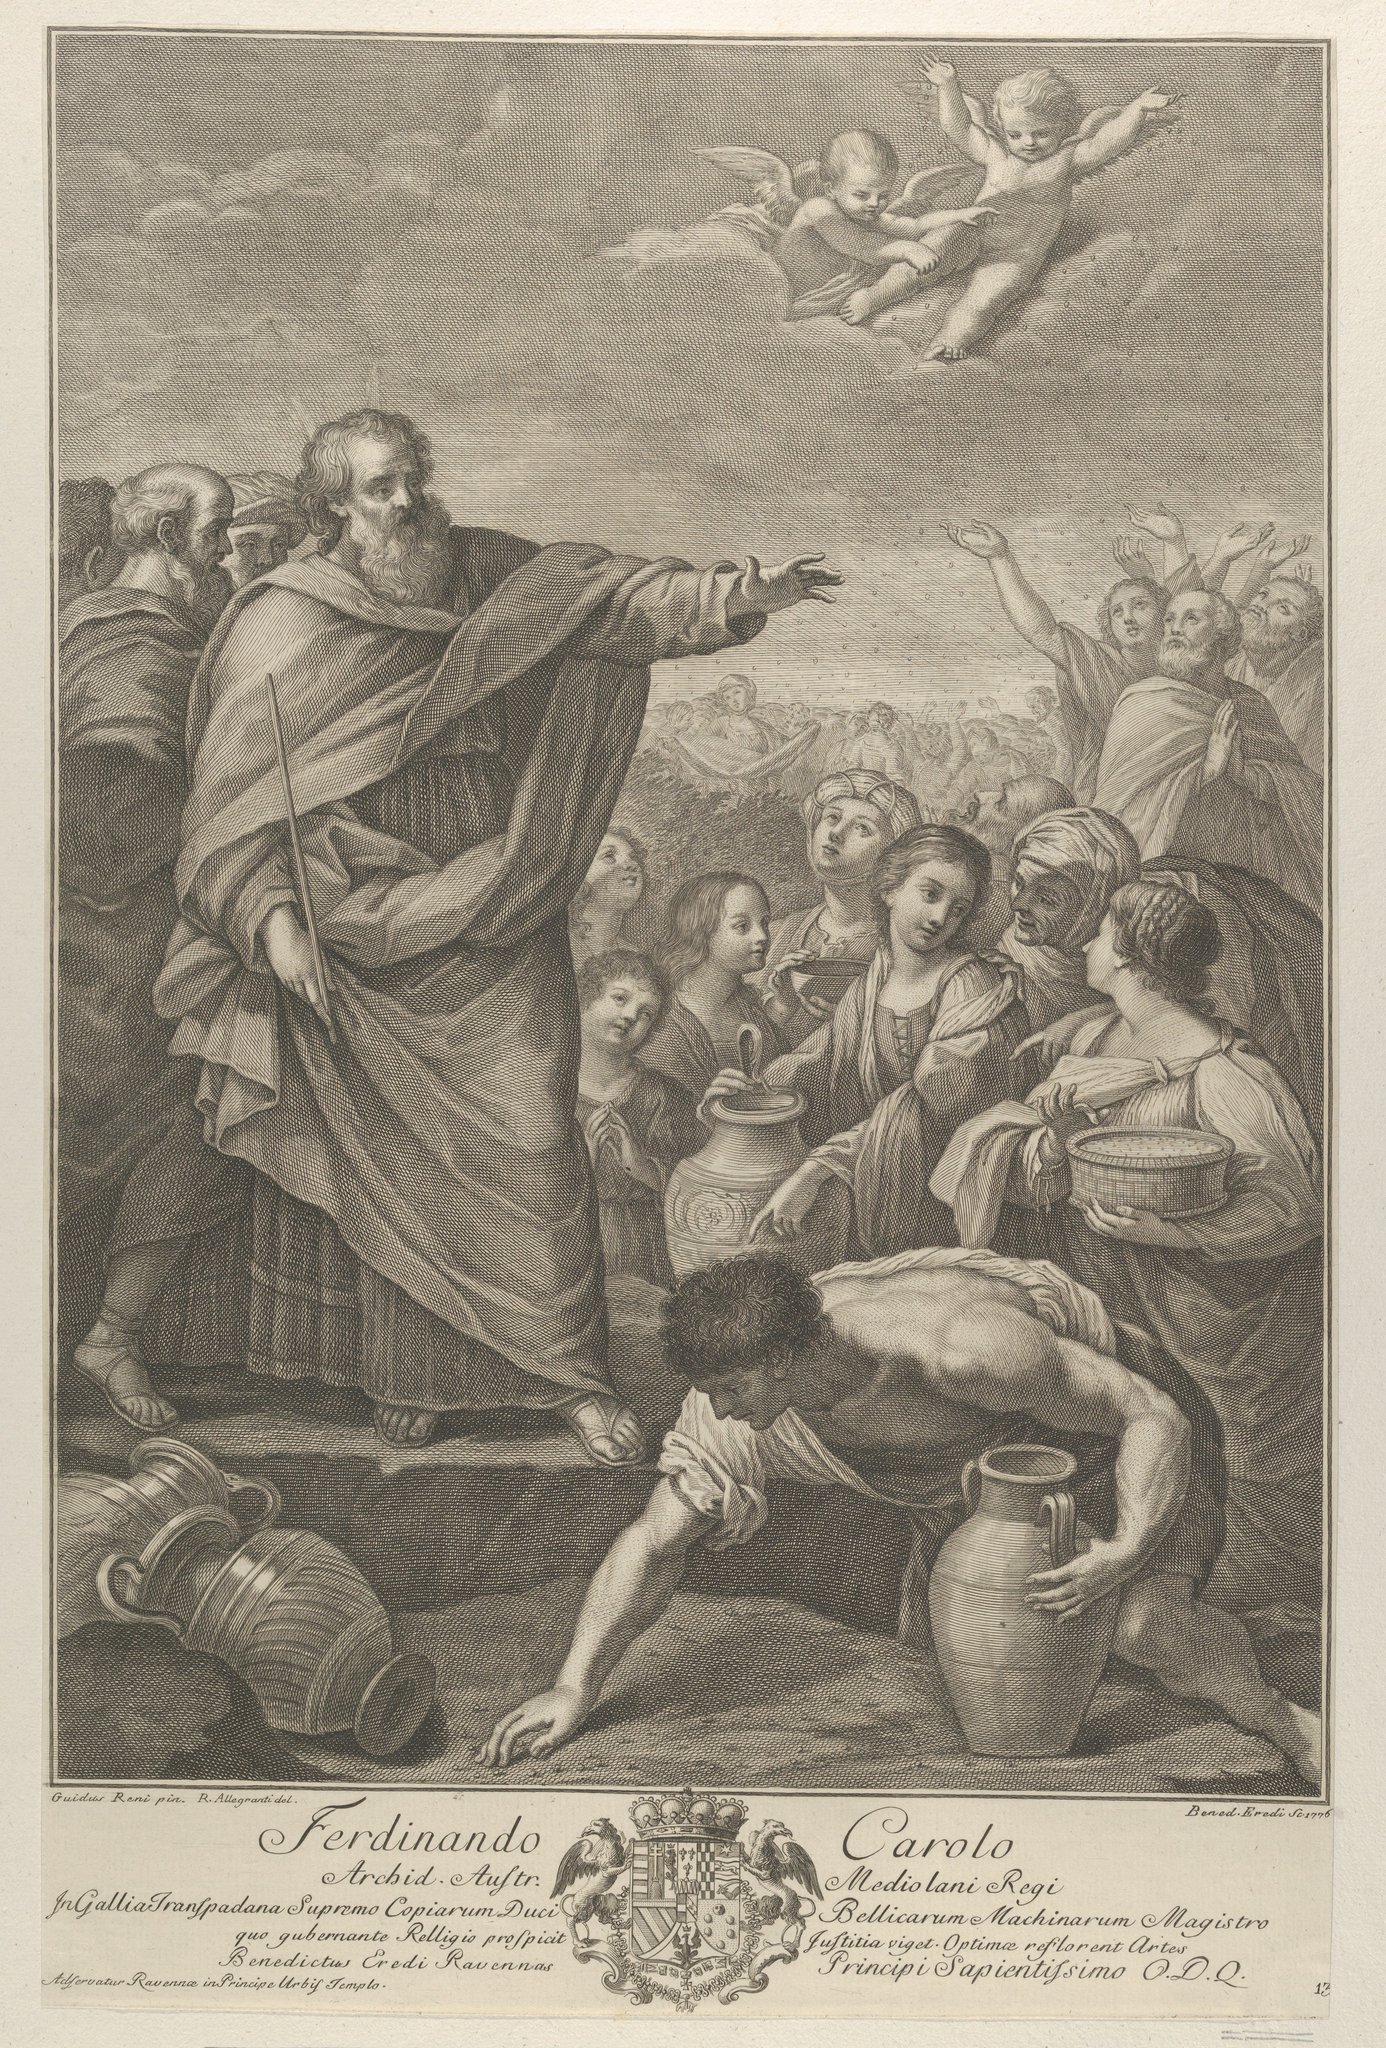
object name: print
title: Moses at left with the Israelites who gather manna as it falls from the sky, two angels above, after Reni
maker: benedetto eredi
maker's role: artist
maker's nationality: italian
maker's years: 1750-1815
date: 1776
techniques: engraving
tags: men,women,angels,moses,coat of arms,manna